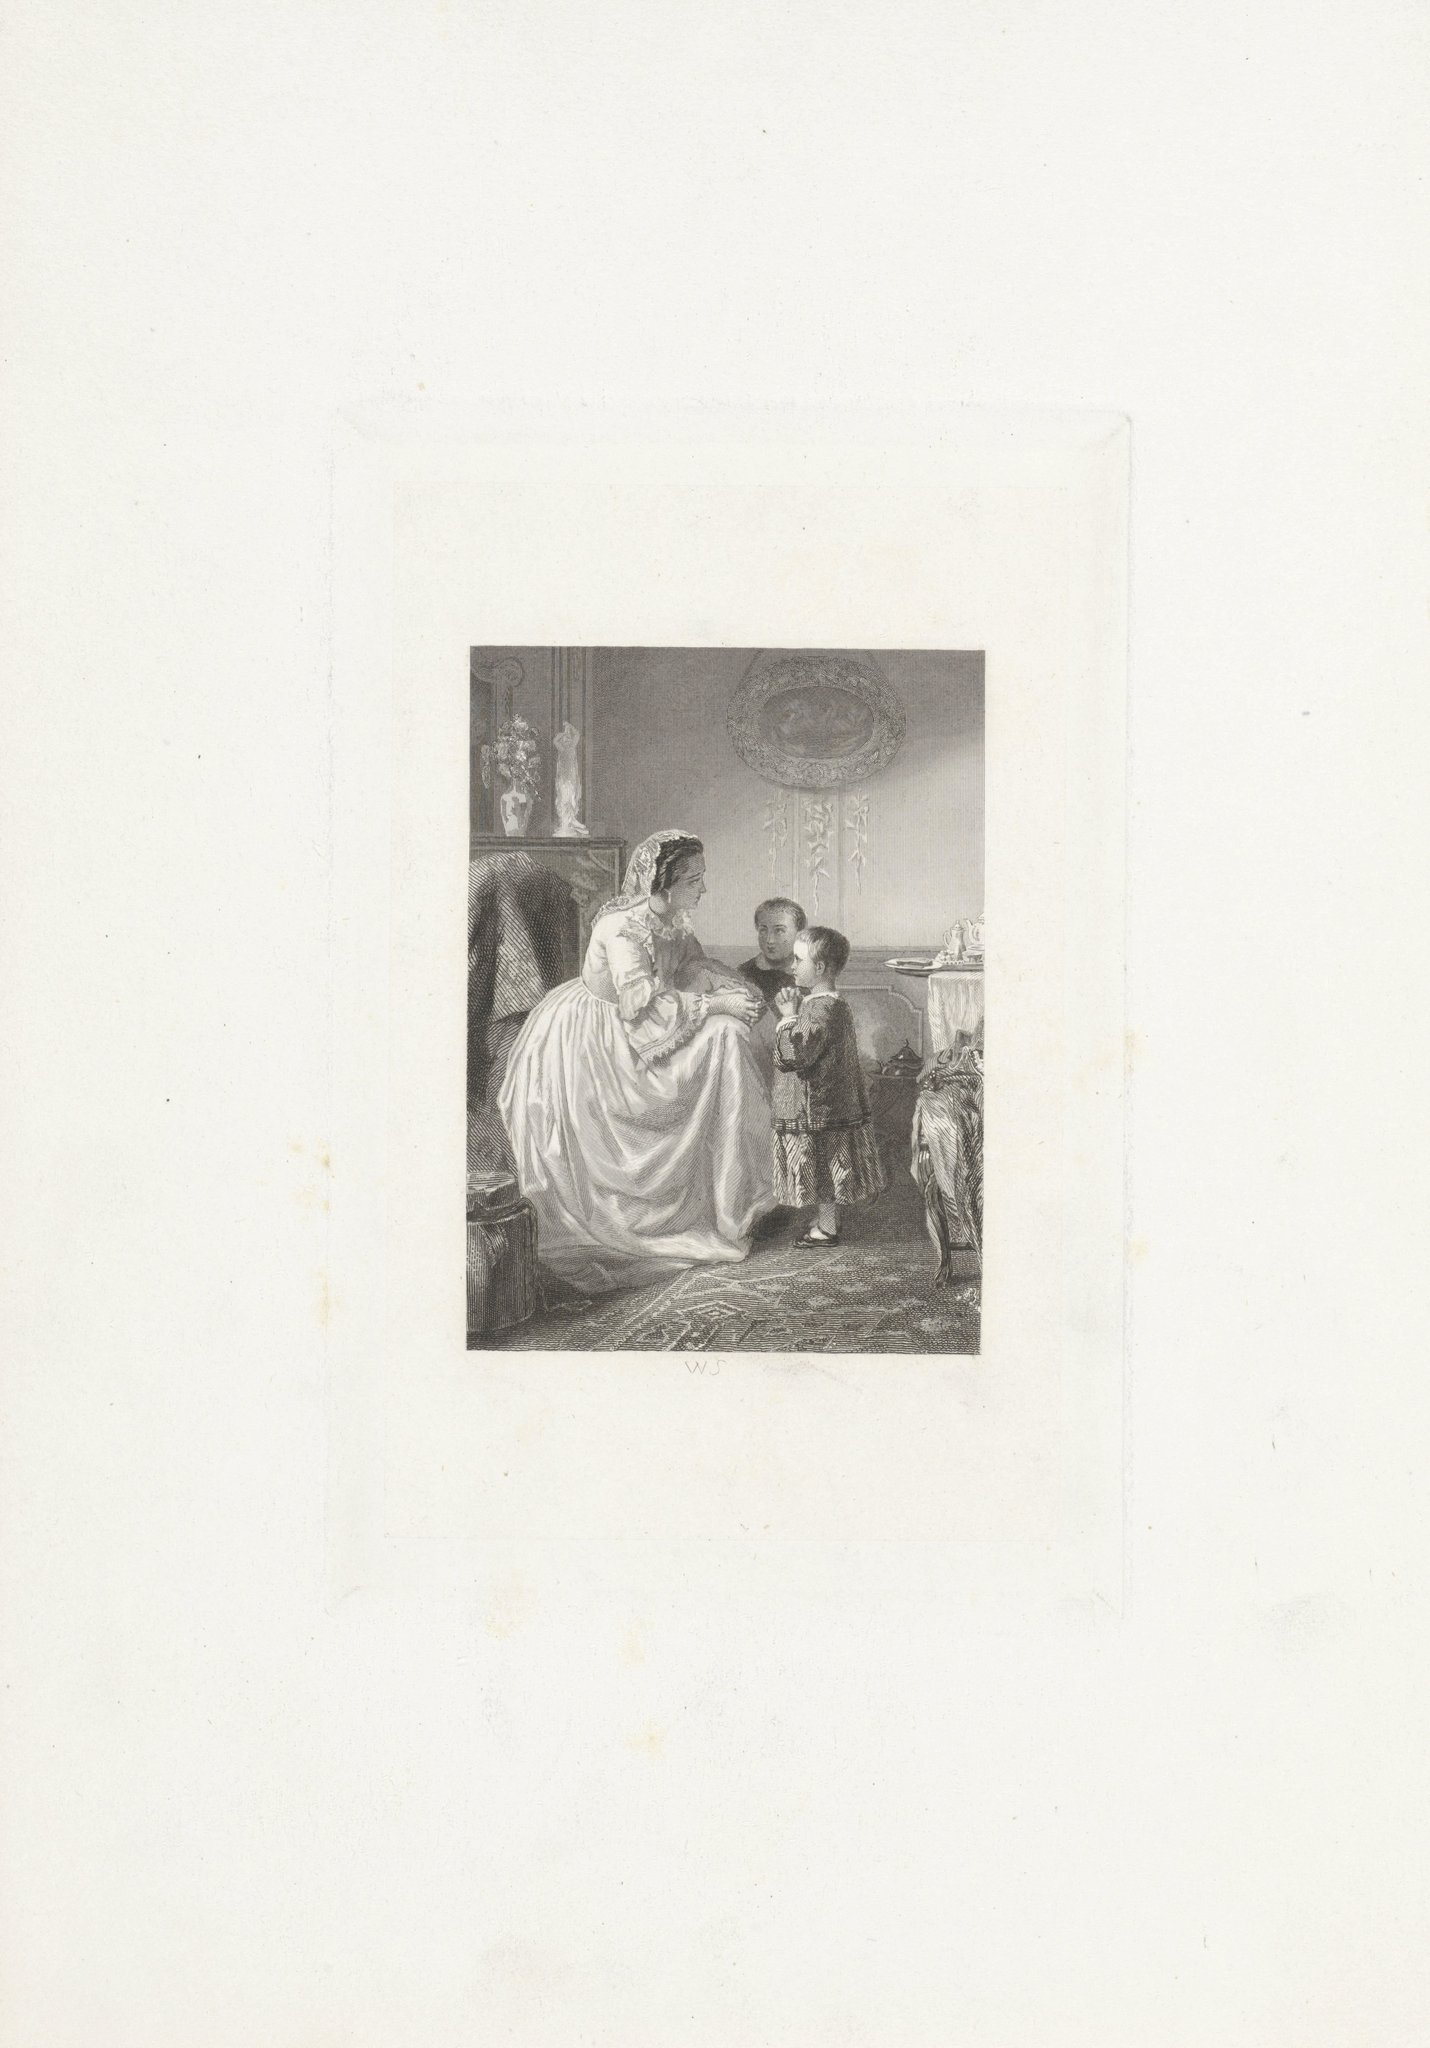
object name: print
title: Interieur met een moeder en twee kinderen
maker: willem steelink (i)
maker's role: draughtsman, print maker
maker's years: 1826-1913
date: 1836-1913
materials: paper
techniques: etching, engraving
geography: amsterdam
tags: hands folded with fingers knit, mother and child(ren), woman and child(ren) (family group)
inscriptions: collector's mark: Lugt 2233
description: Interieur met een zittende moeder. Twee kinderen staan bij haar. Zij houden hun handen gevouwen.